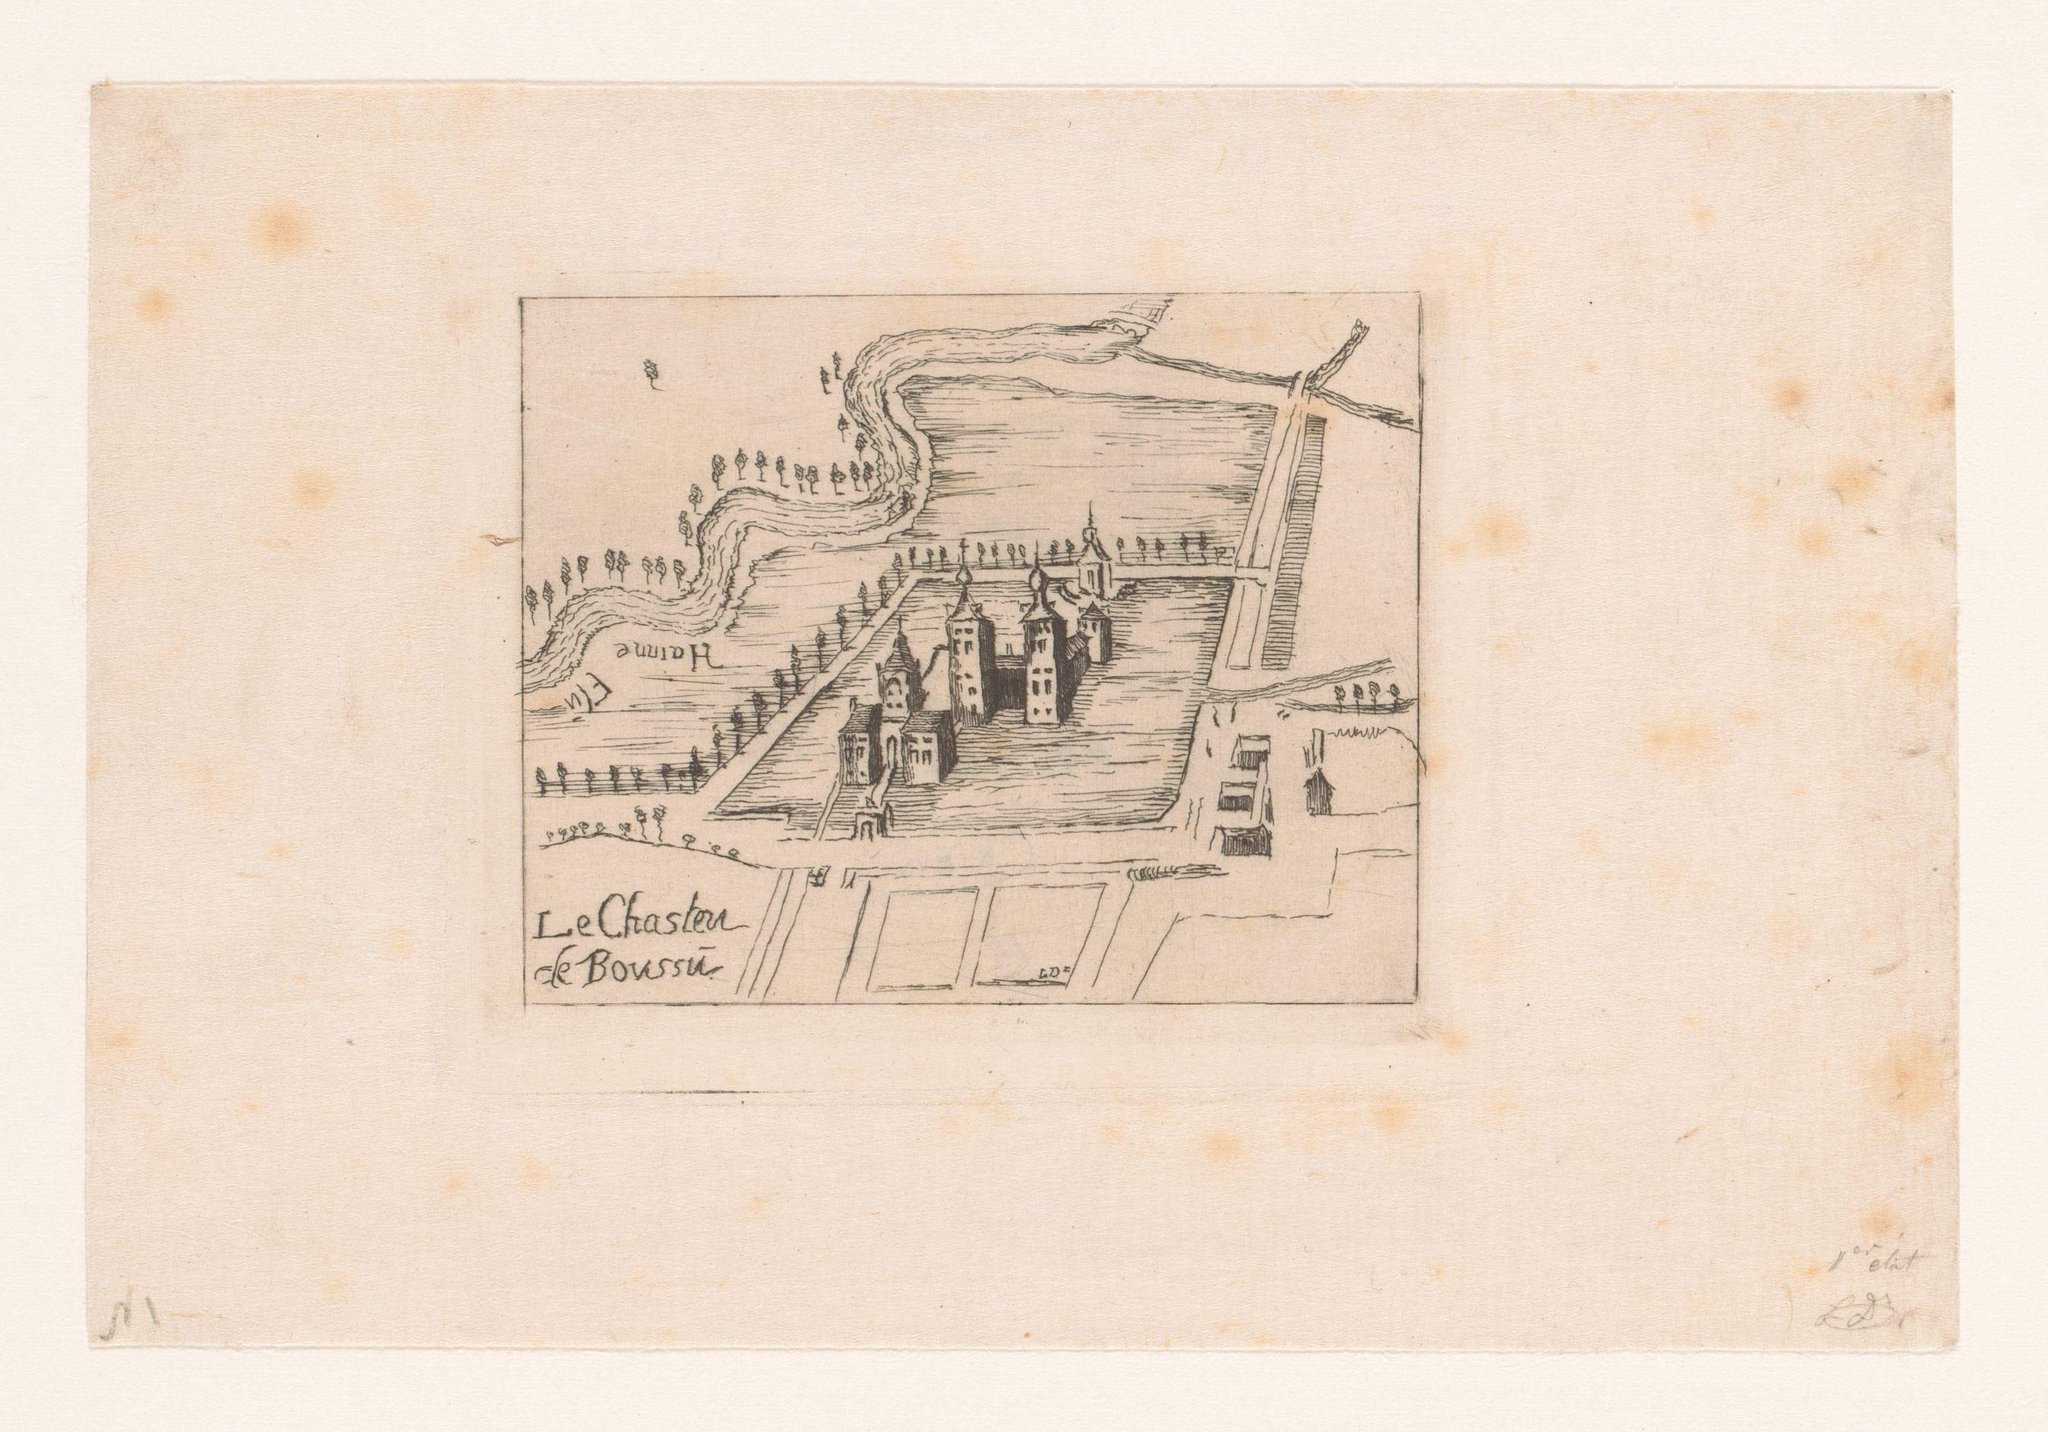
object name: print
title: Le Chasteu de Boussu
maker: léon dolez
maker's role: print maker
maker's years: 1837-1902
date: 1847-1902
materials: paper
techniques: etching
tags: castle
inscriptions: inscription: ‘1e etat’, collector's mark: Lugt 2228